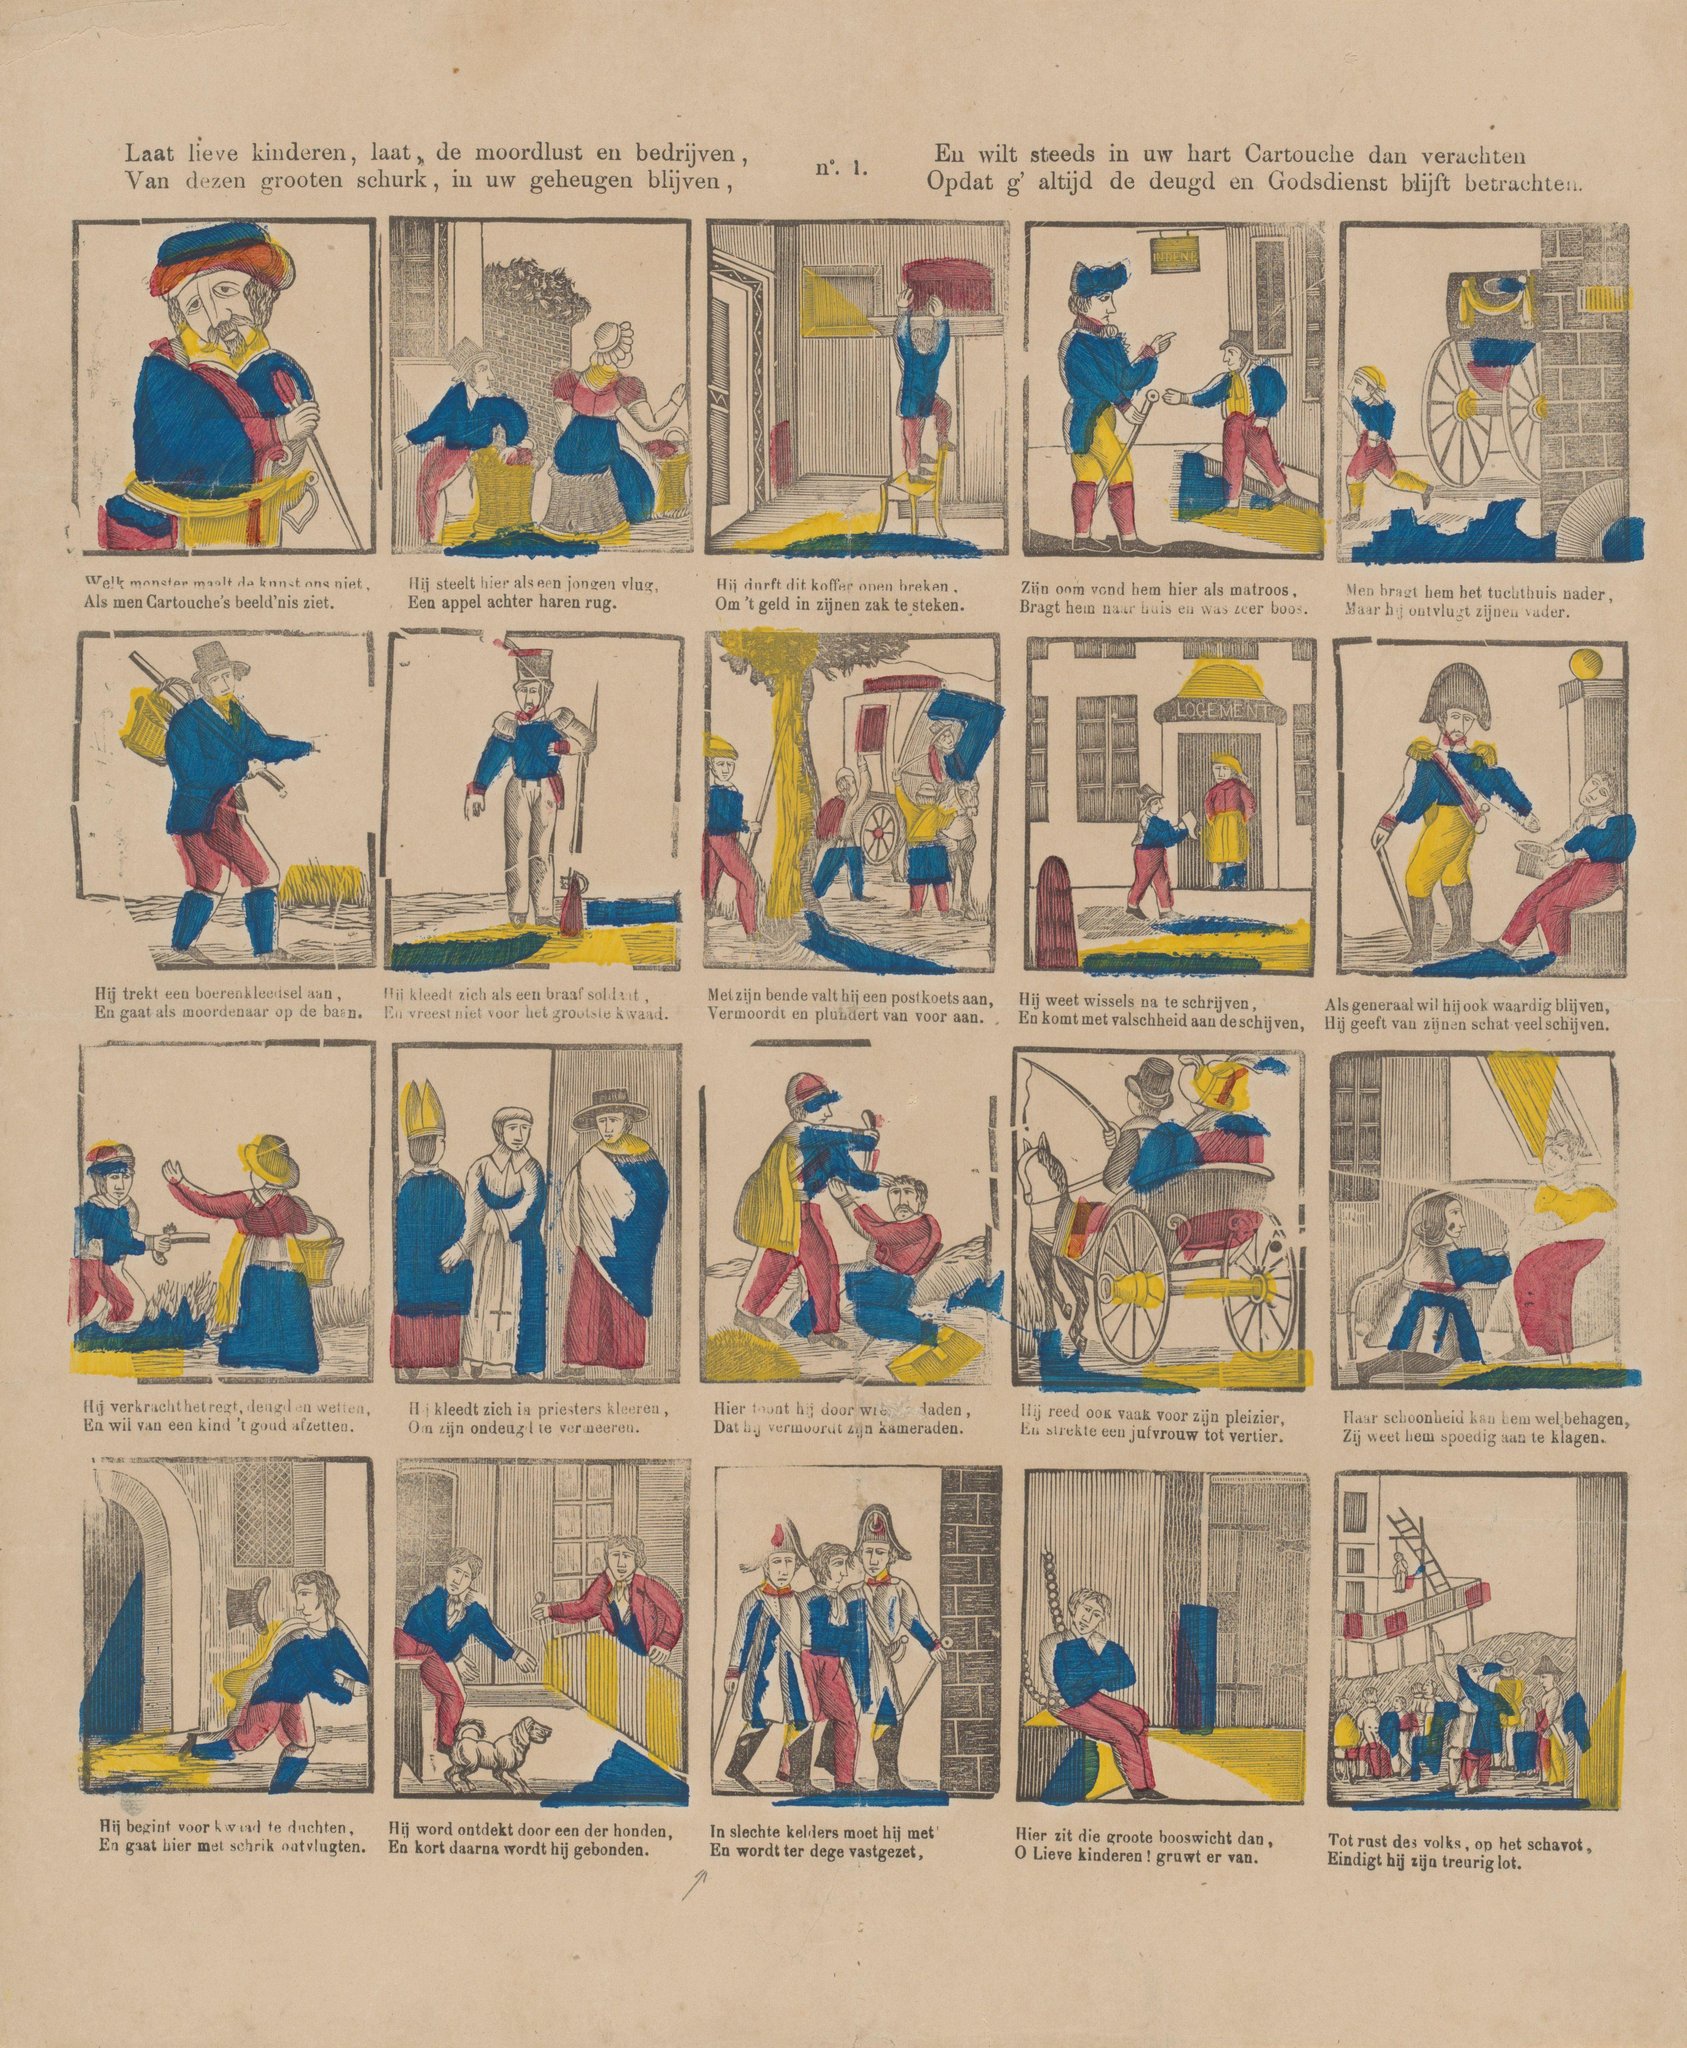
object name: popular print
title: Laat lieve kinderen, laat, de moordlust en bedrijven, / Van dezen grooten schurk, in uw geheugen blijven, / En wilt steeds in uw hart Cartouche dan verachten / Opdat g' altijd de deugd en godsdienst blijt betrachten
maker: Anonymous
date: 1848-1881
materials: paper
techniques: colour, letterpress printing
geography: netherlands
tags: violent death by hanging, bad behaviour, tales and fairy tales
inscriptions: collector's mark: Lugt 2760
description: Blad met 20 voorstellingen over het leven en avonturen van Cartouche. Onder elke afbeelding een tweeregelig vers. Genummerd midden boven: no. 1.